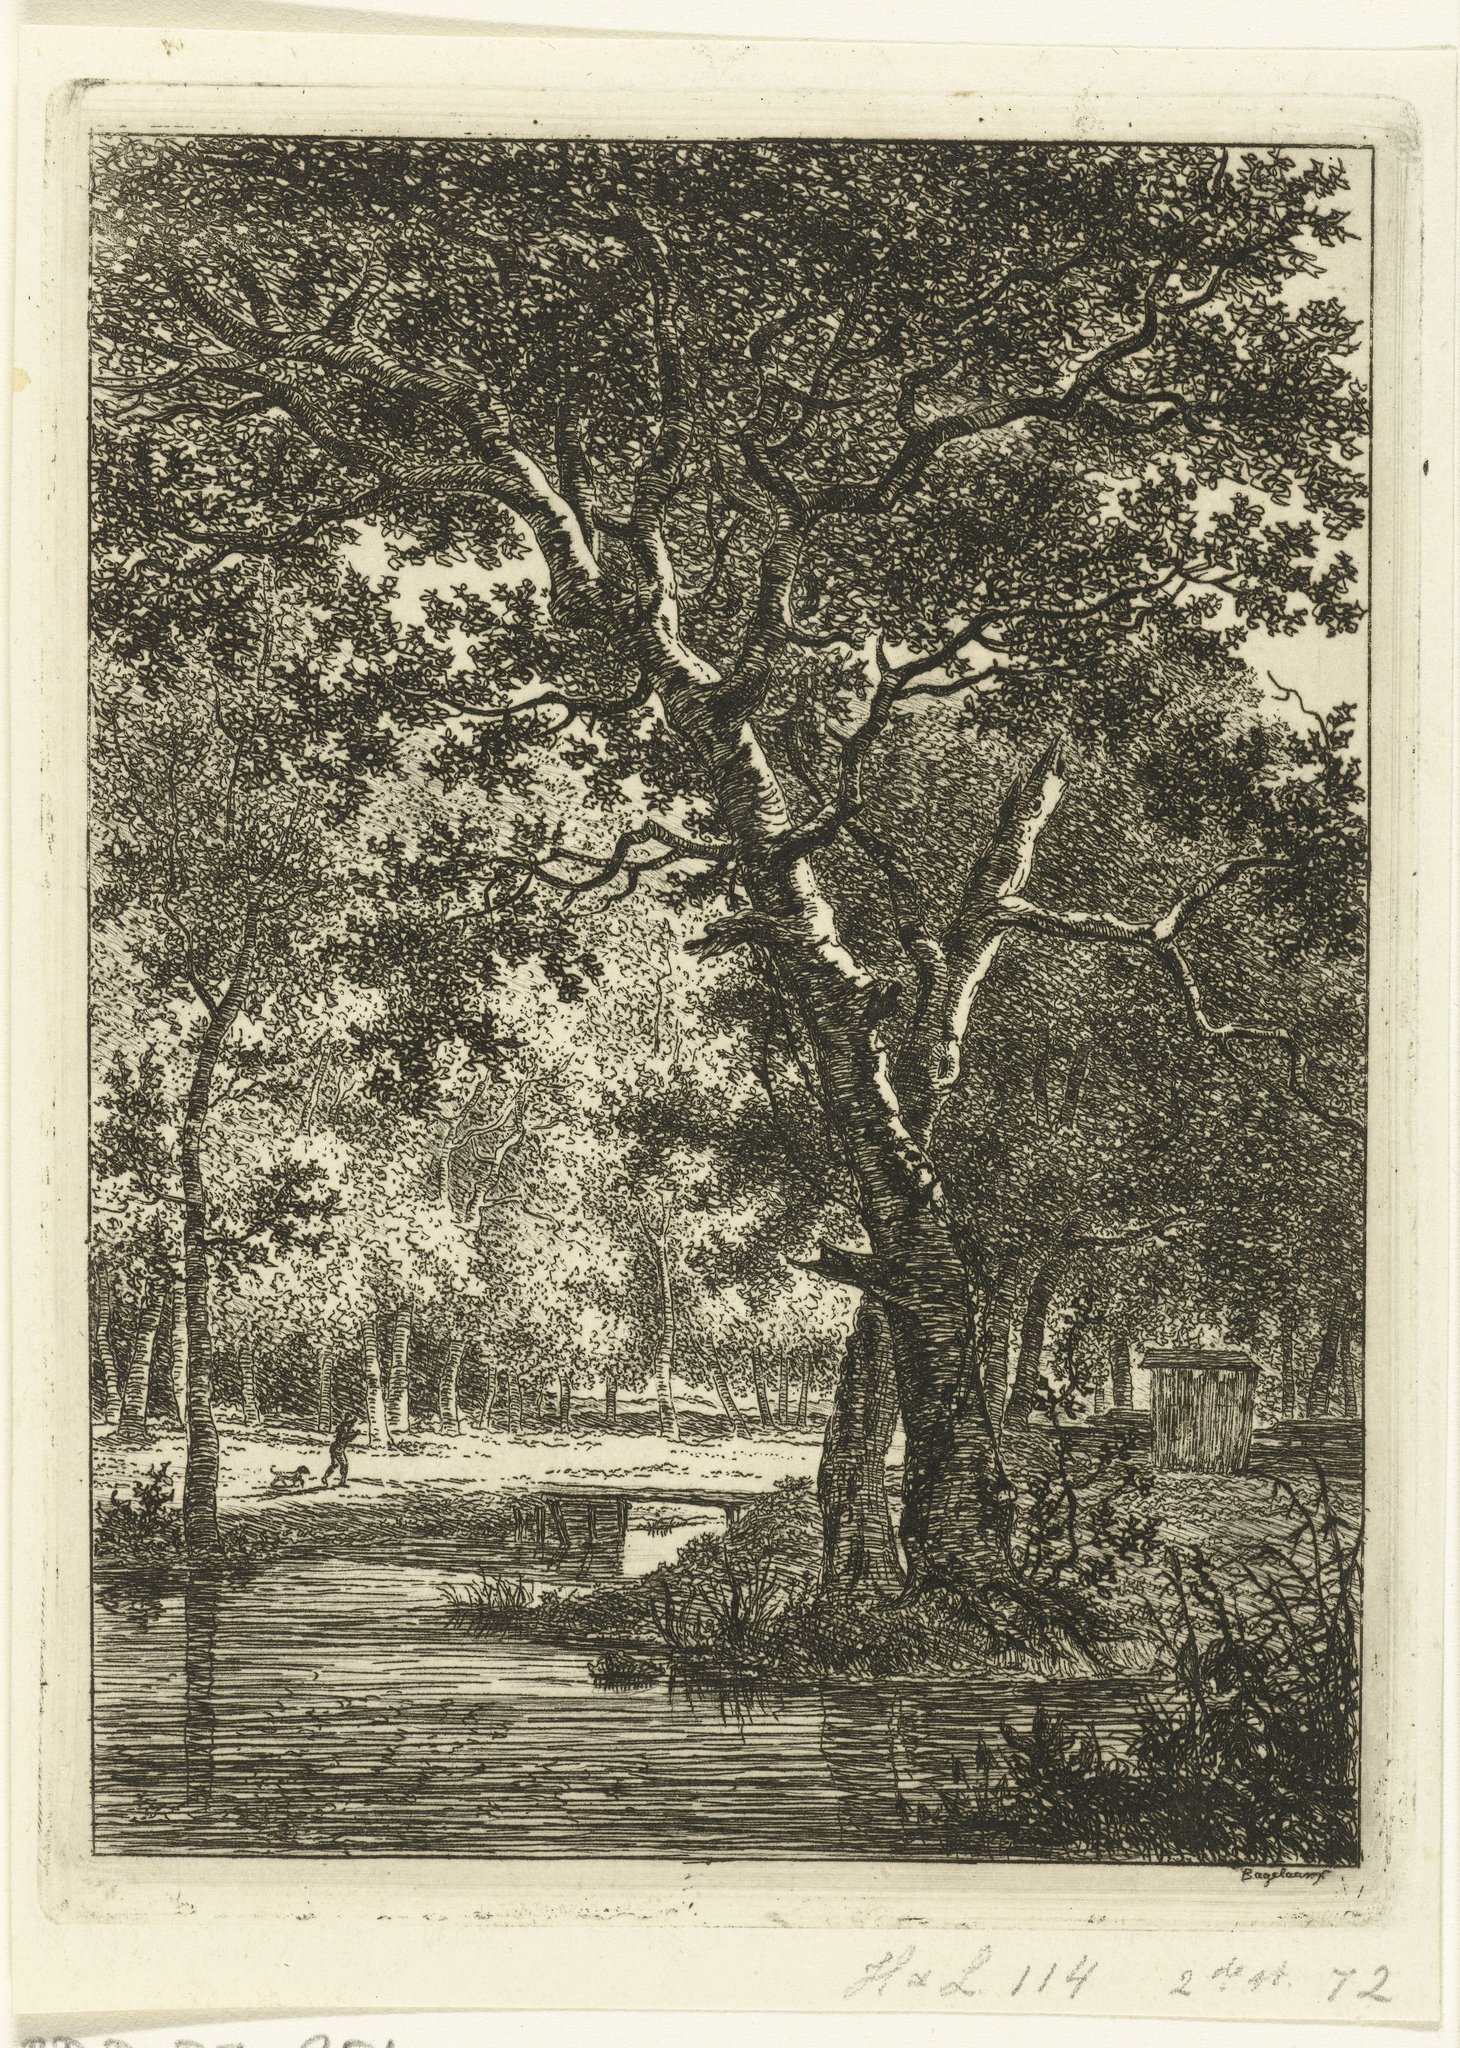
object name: print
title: Boslandschap met man en hond bij een brug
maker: ernst willem jan bagelaar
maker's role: draughtsman, print maker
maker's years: 1775-1837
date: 1798-1837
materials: paper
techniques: drypoint, etching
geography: netherlands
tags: forest, wood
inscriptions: collector's mark: Lugt 2228